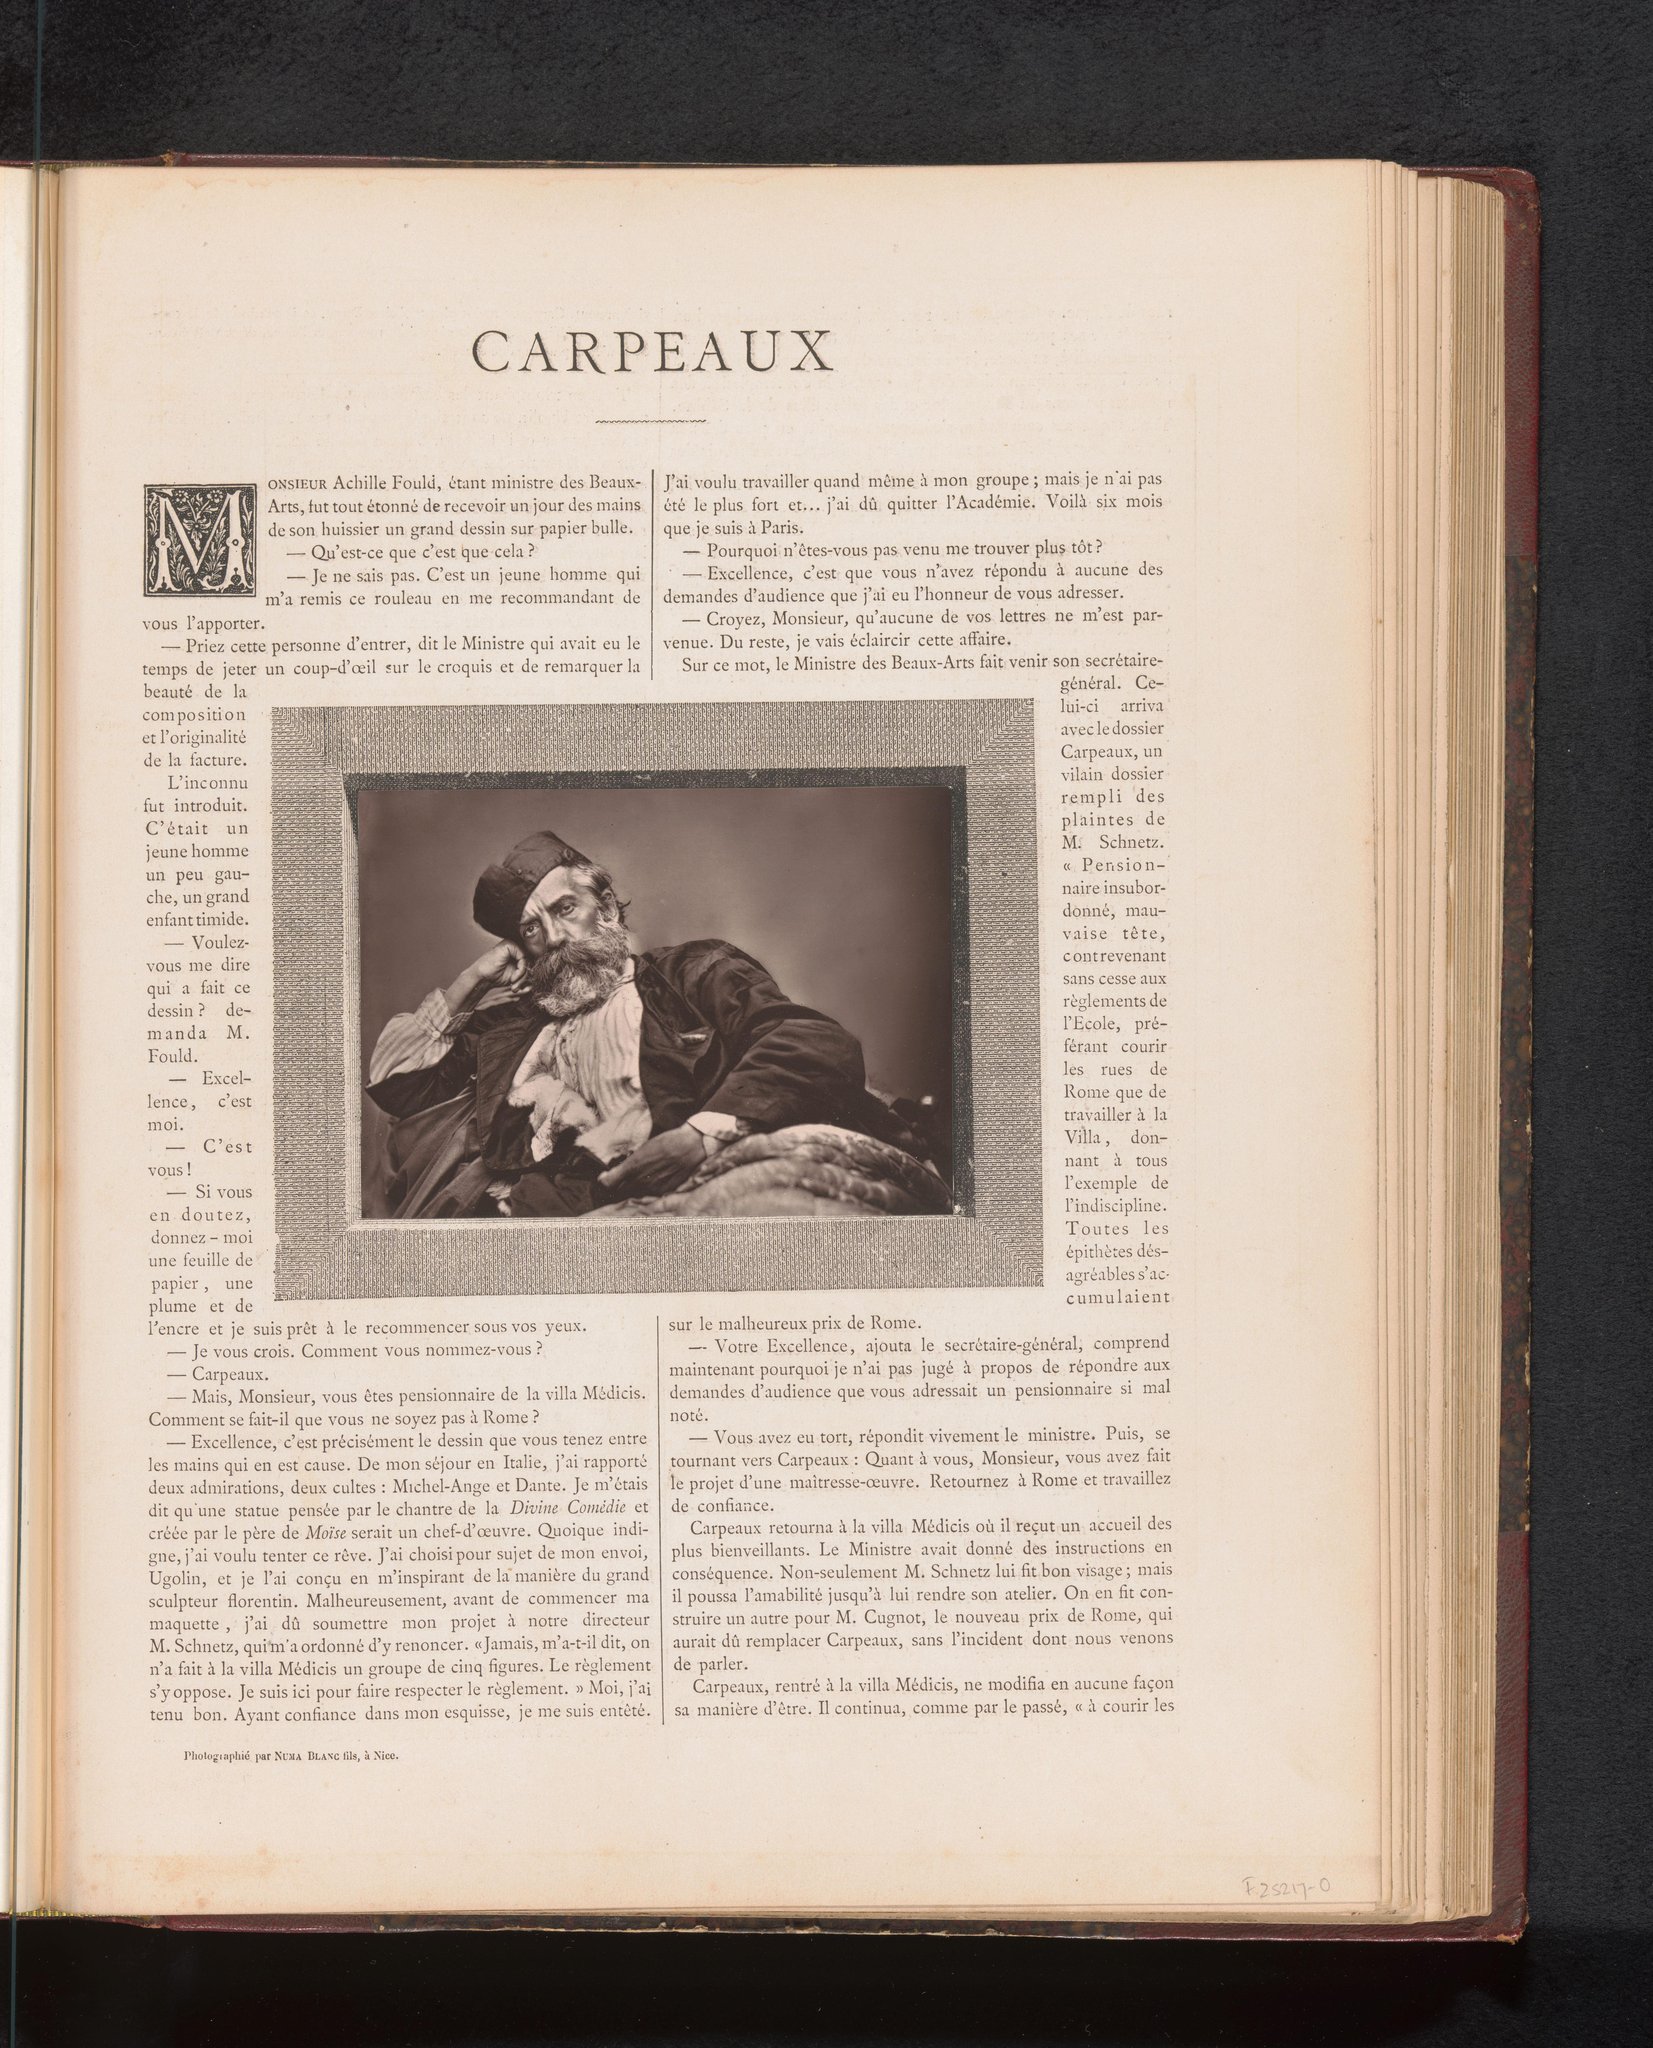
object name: photomechanical print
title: Portret van Jean-Baptiste Carpeaux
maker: Anonymous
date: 1872-1877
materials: paper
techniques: printing block, woodburytype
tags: print maker, sculptor, jean baptiste carpeaux, adult man, historical persons